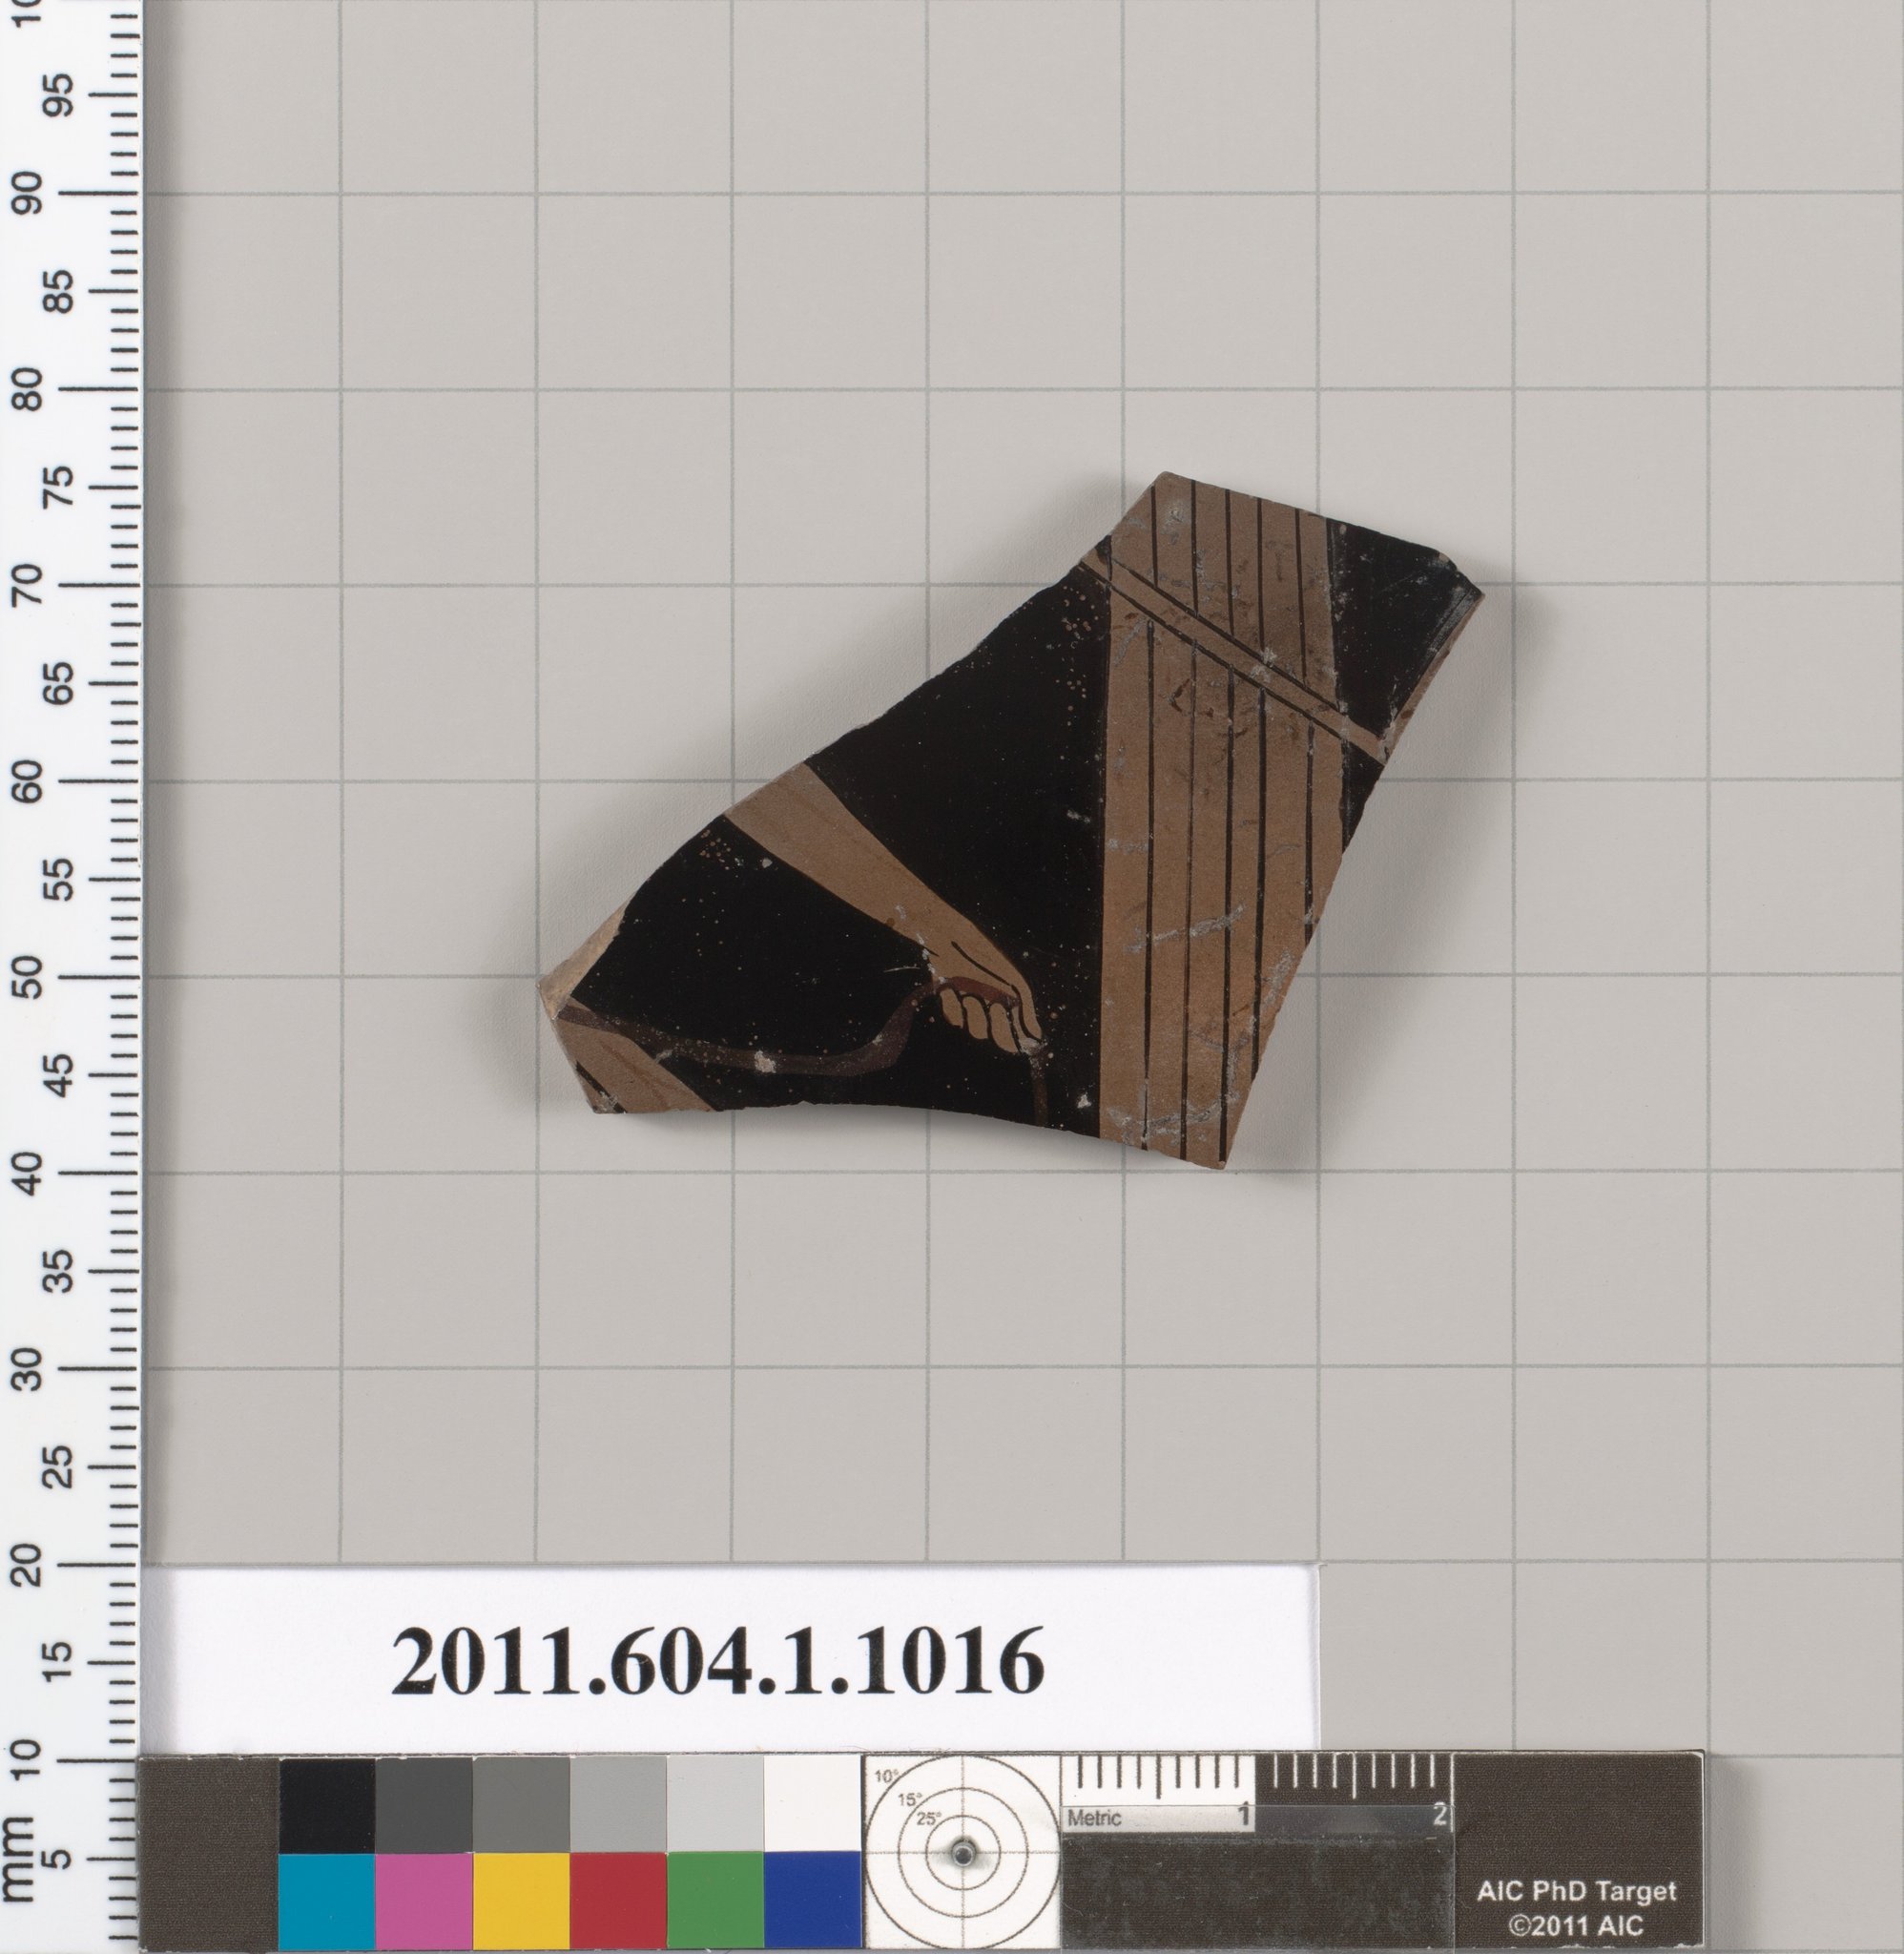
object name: kylix fragment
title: Terracotta fragment of a kylix (drinking cup)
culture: greek, attic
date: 475-451 BCE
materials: terracotta